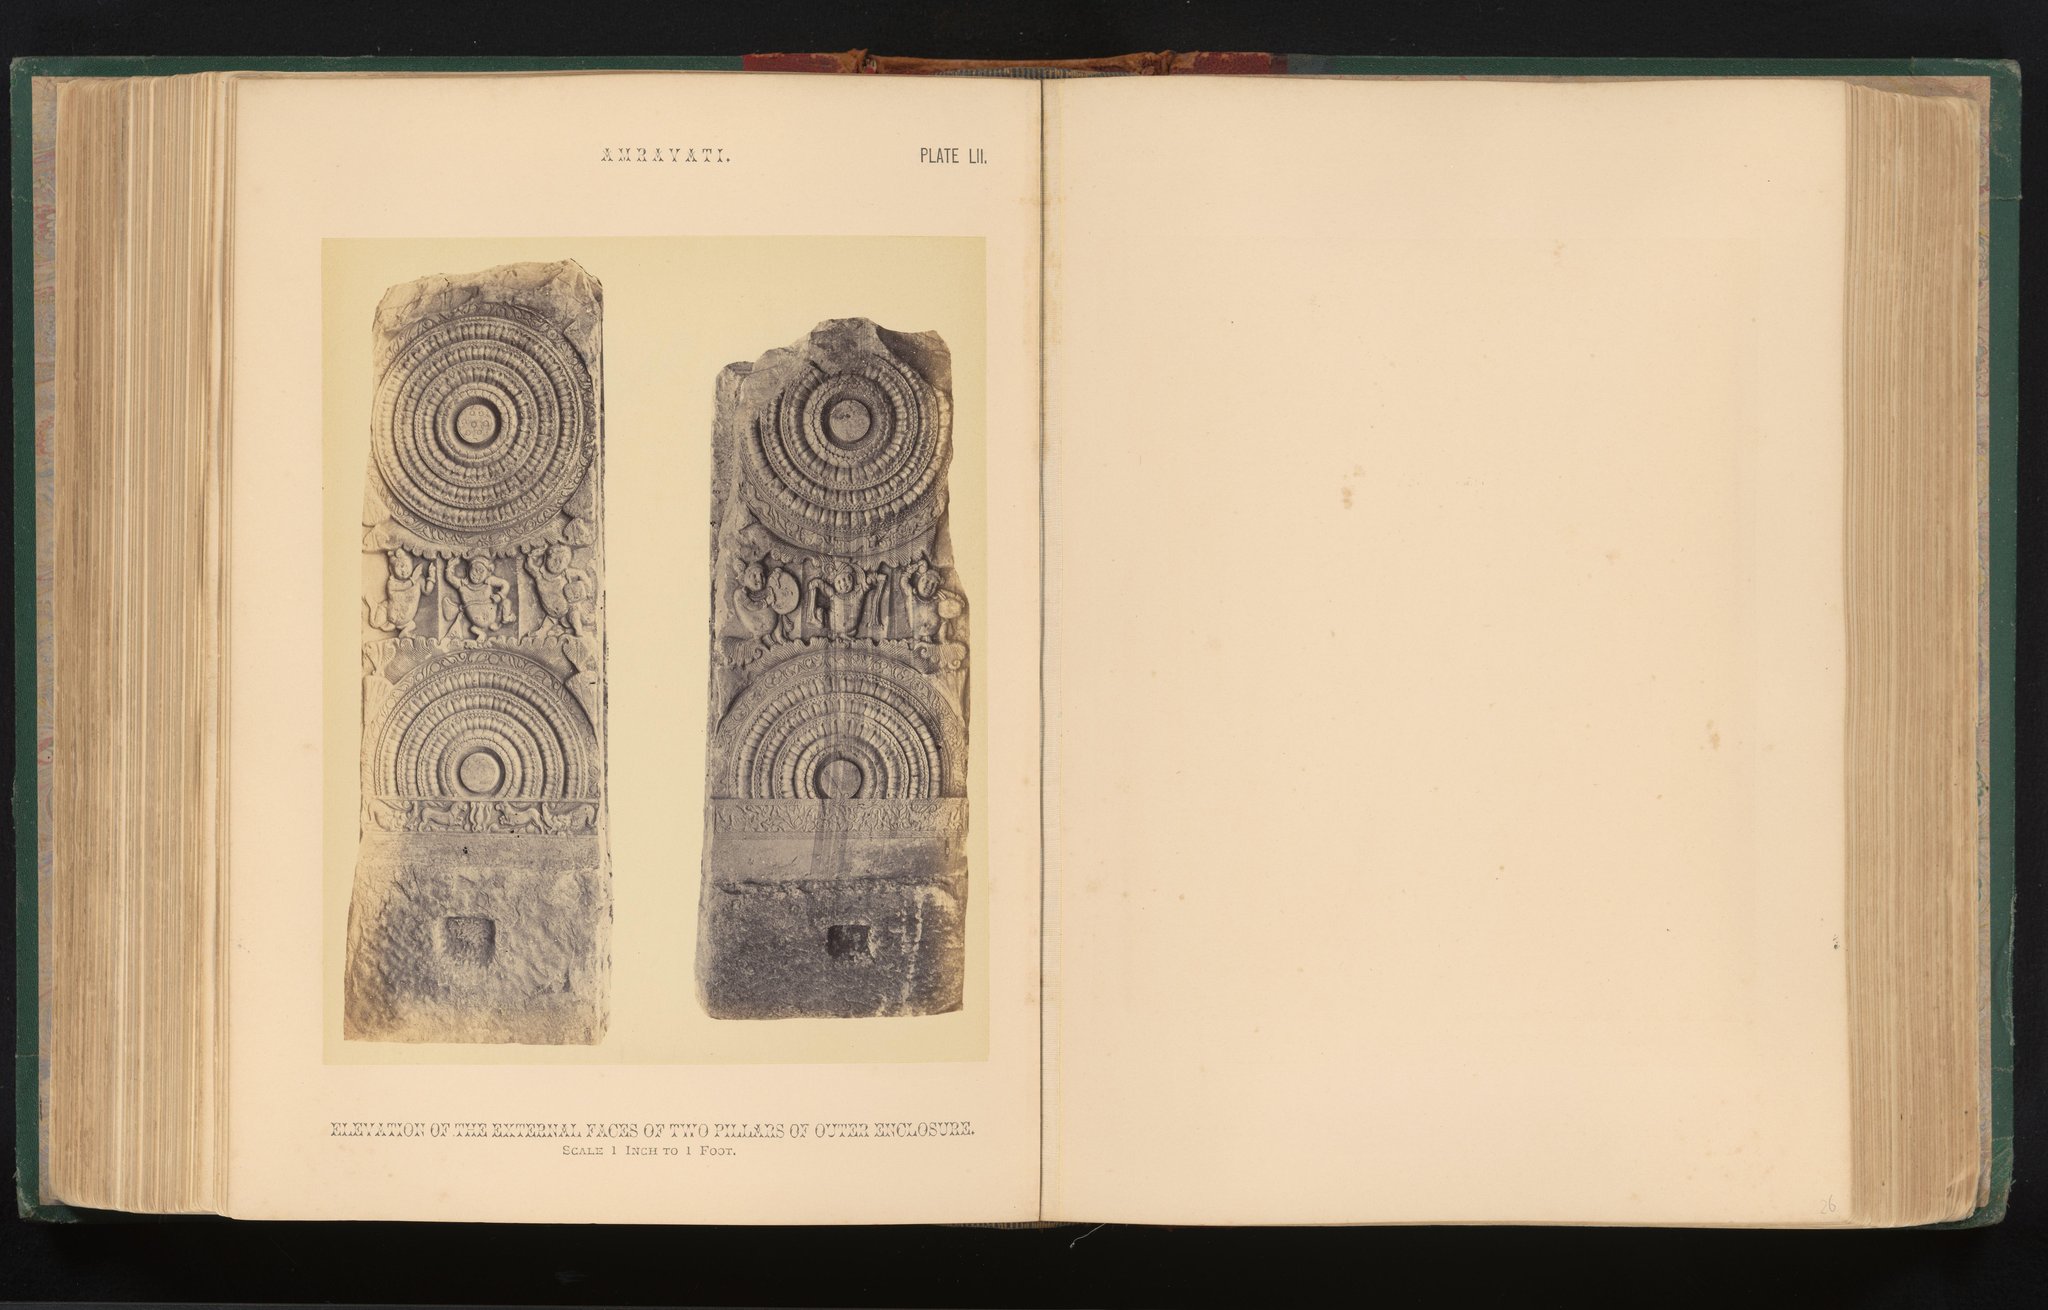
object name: page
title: Pillars with relief, Amaravati, Andhra Pradesh, India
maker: william h. griggs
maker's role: printer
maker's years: 1832-1911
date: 1863-1868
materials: photographic support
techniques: albumen print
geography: amaravati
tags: hinduism, buddhism, jainism, column, pillar ~ architecture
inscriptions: inscription: ‘ELEVATION OF THE EXTERNAL FACES OF TWO PILLARS OF OUTER ENCLOSURE./ SCALE 1 INCH TO 1 FOOT.’, inscription: ‘AMRAVATI. PLATE LII.’